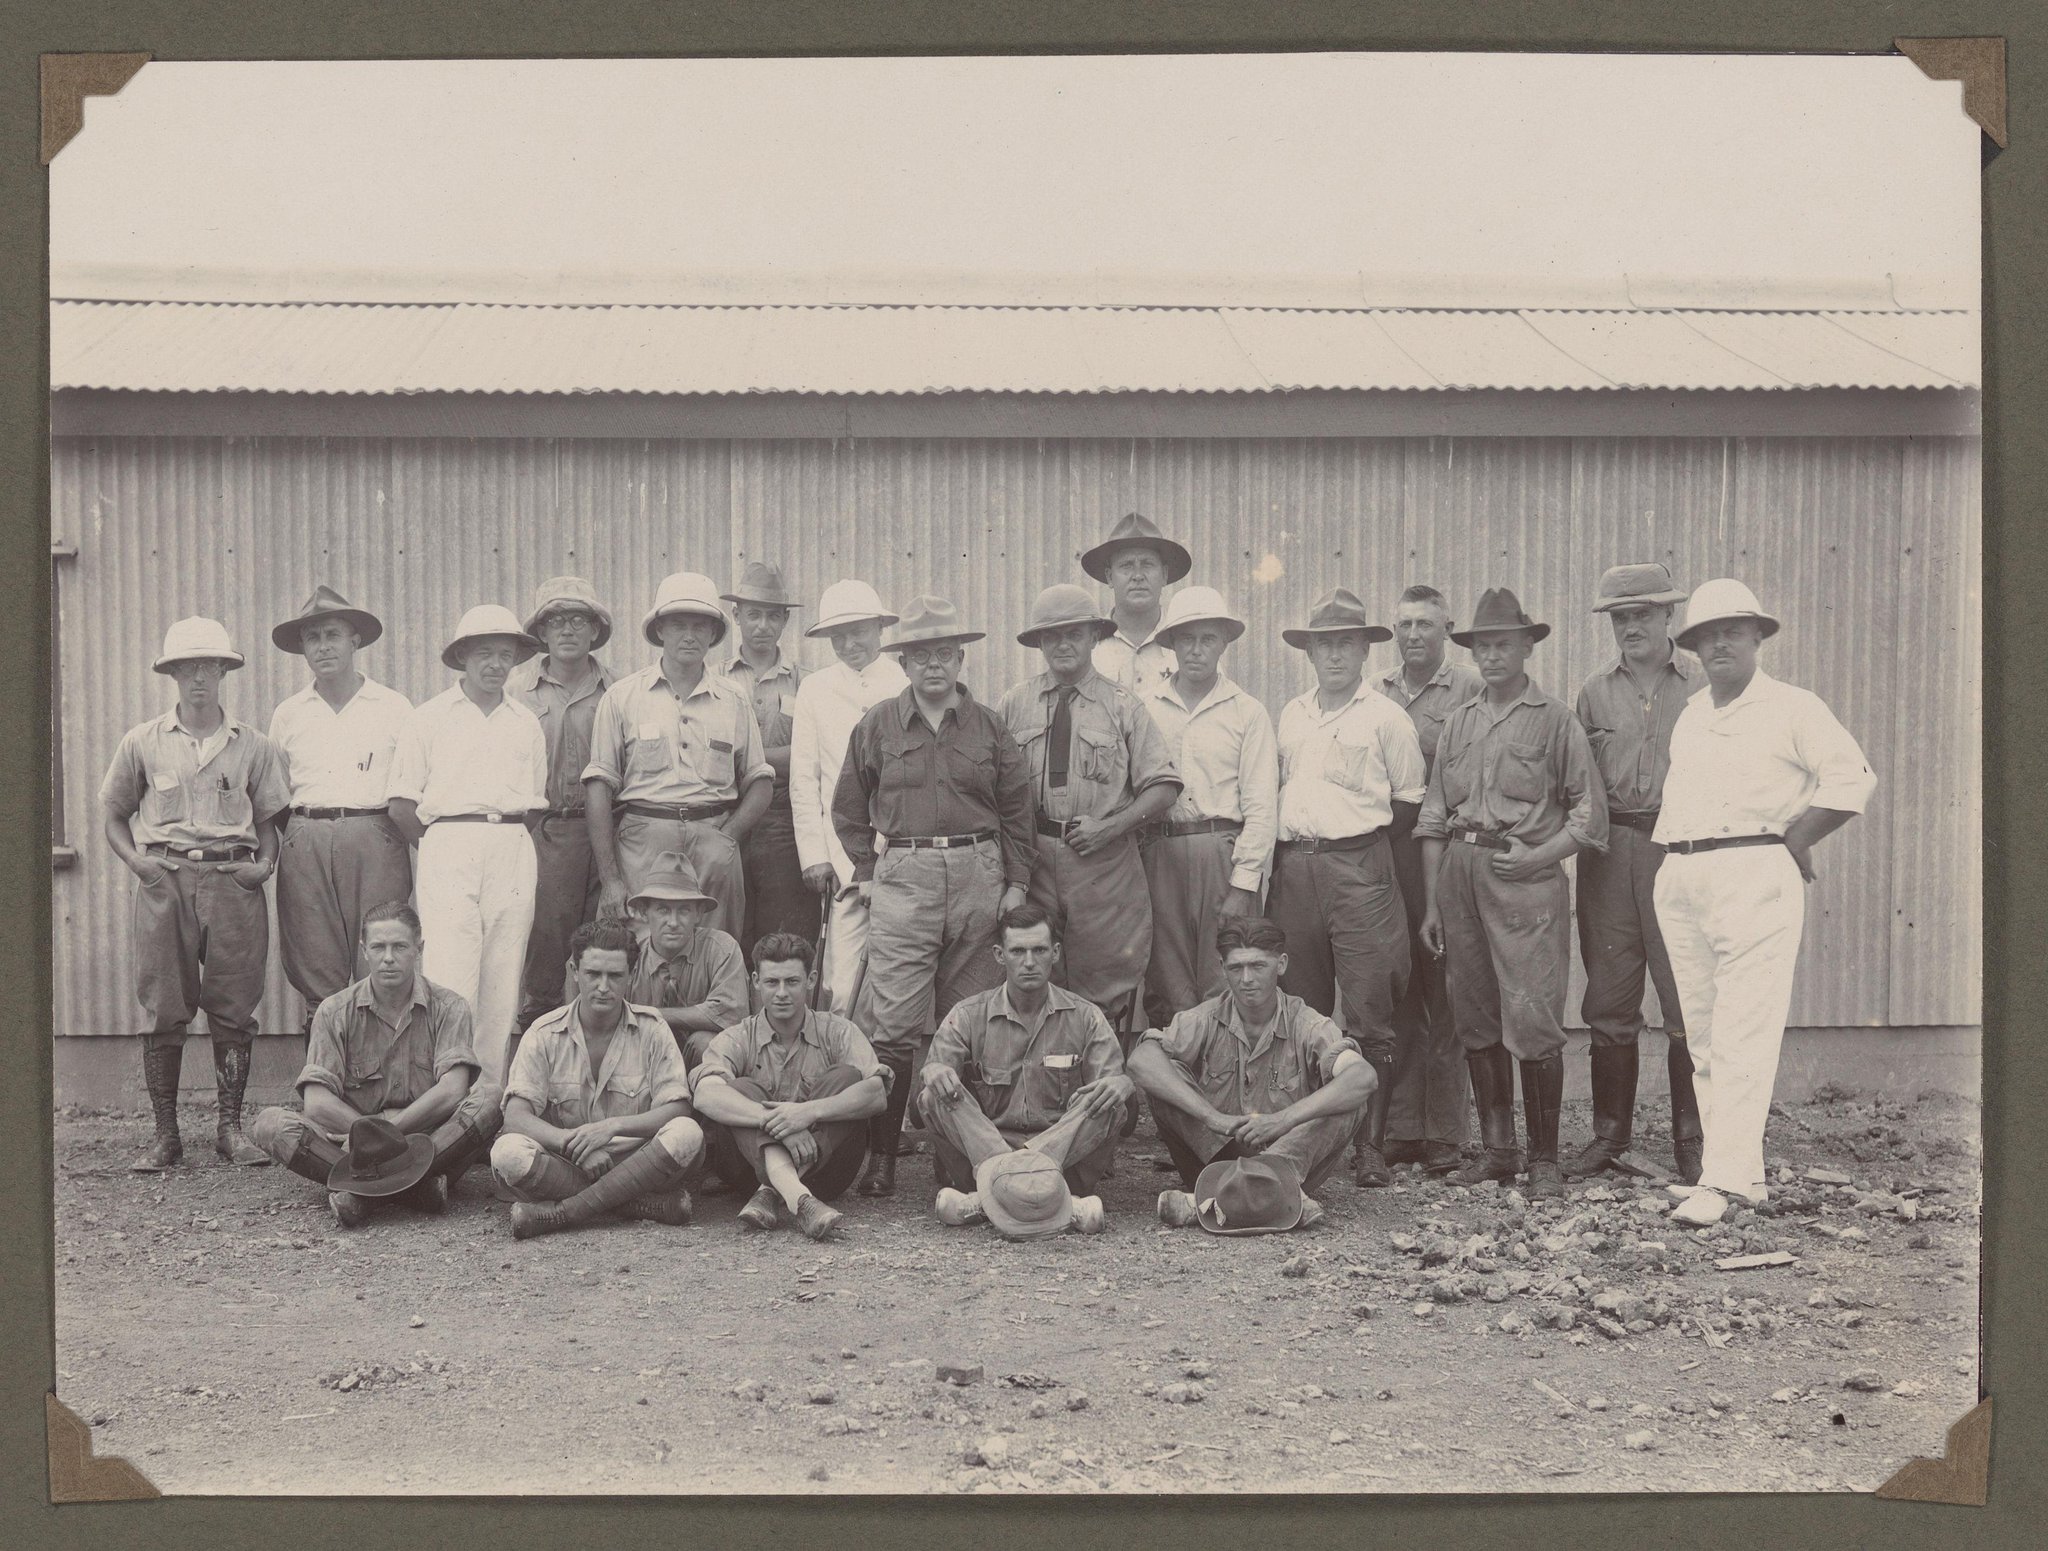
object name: photograph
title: Groepsfoto van het Nederlandse personeel op de mijn te Moengo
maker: Anonymous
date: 1925-1927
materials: photographic support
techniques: photography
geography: suriname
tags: jetten, familie, moengo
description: Groepsfoto van het Nederlandse personeel op de mijn te Moengo. Foto op een bladzijde van een los albumblad. Onderdeel van het ensemble met foto's van de familie van ingenieur Jetten in de mijnbouwstad Moengo in Suriname.